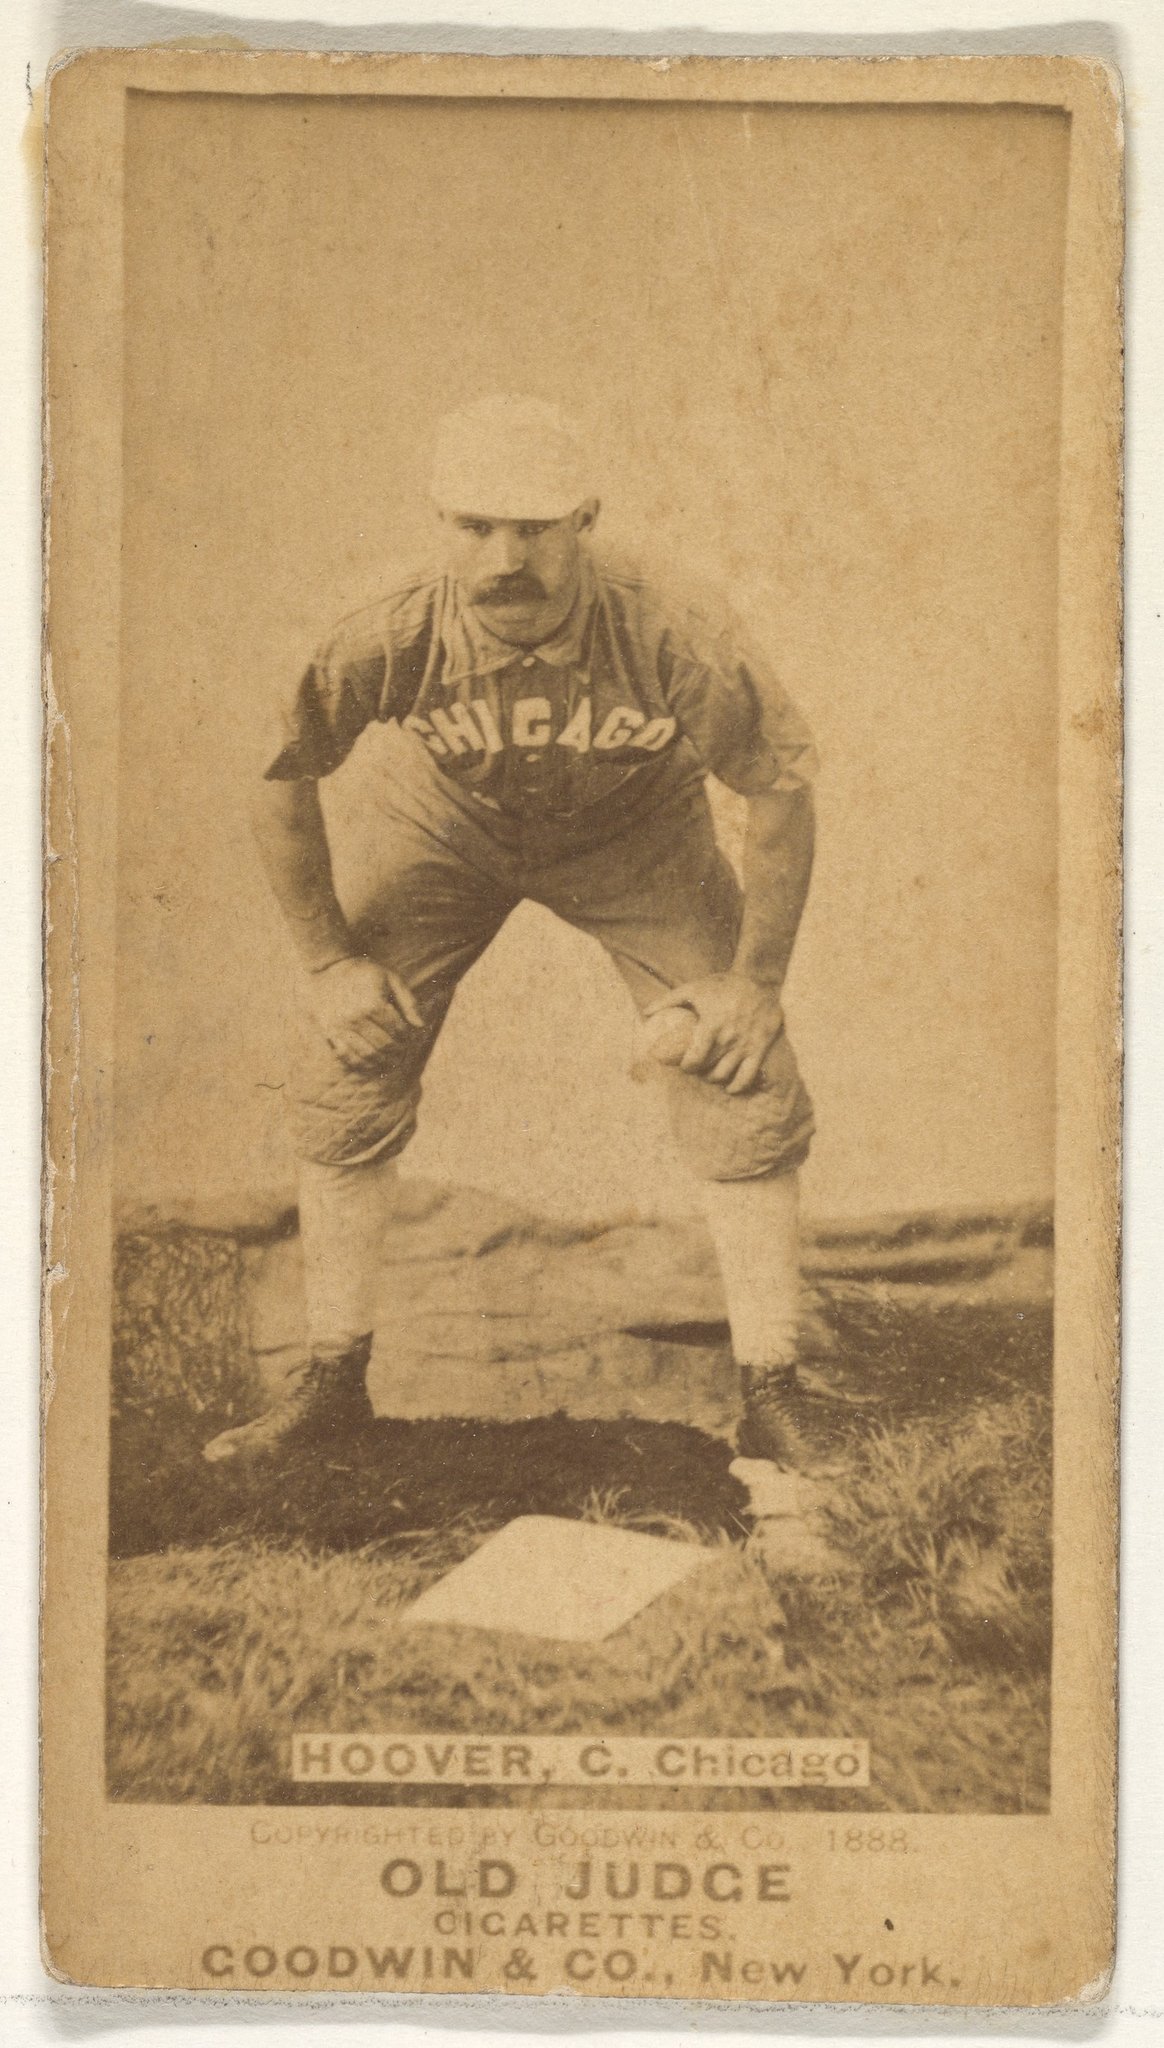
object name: baseball card, photograph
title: C.E. Hoover, Catcher, Chicago, from the Old Judge series (N172) for Old Judge Cigarettes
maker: goodwin & company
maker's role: publisher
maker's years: 1850-1950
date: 1888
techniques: albumen silver print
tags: men,portraits,baseball,athletes